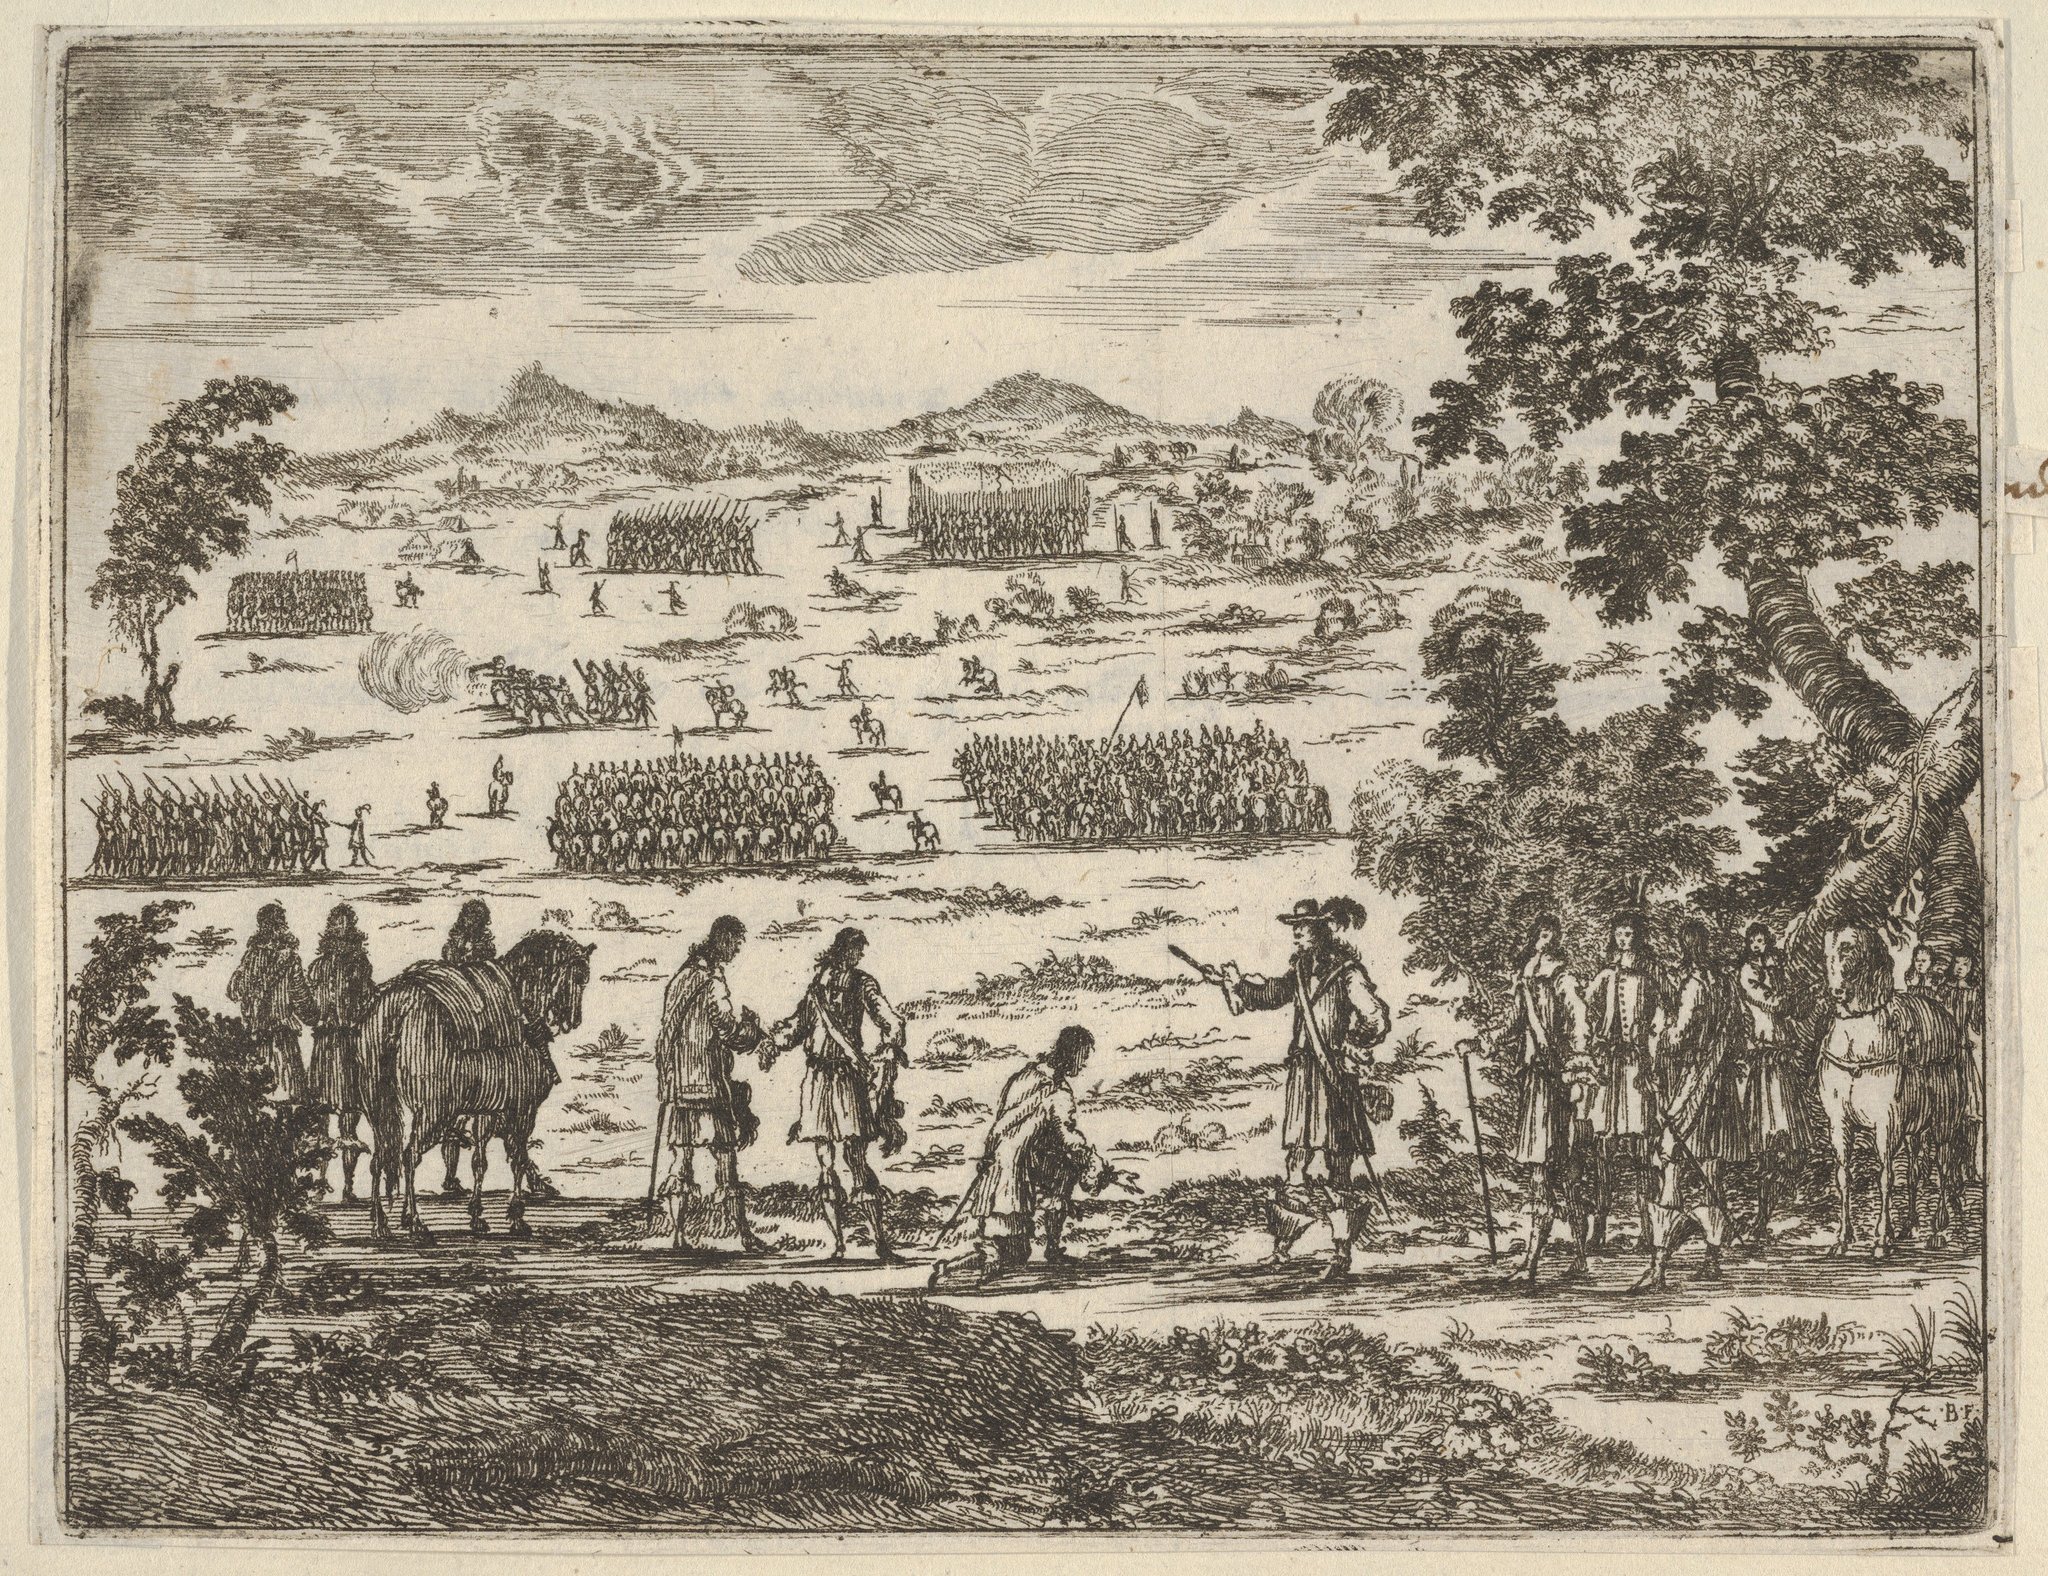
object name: print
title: Francesco I d'Este Sentences a Noble French Official to Death as an Example to Prevent Future Scandalous Excesses within the Church, from "L'Idea di un Principe ed Eroe Cristiano in Francesco I d'Este, di Modena e Reggio Duca VIII [...]"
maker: bartolomeo fenice (fénis)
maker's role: artist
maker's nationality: italian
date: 1659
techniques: etching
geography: italy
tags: battles,weapons,men,horses